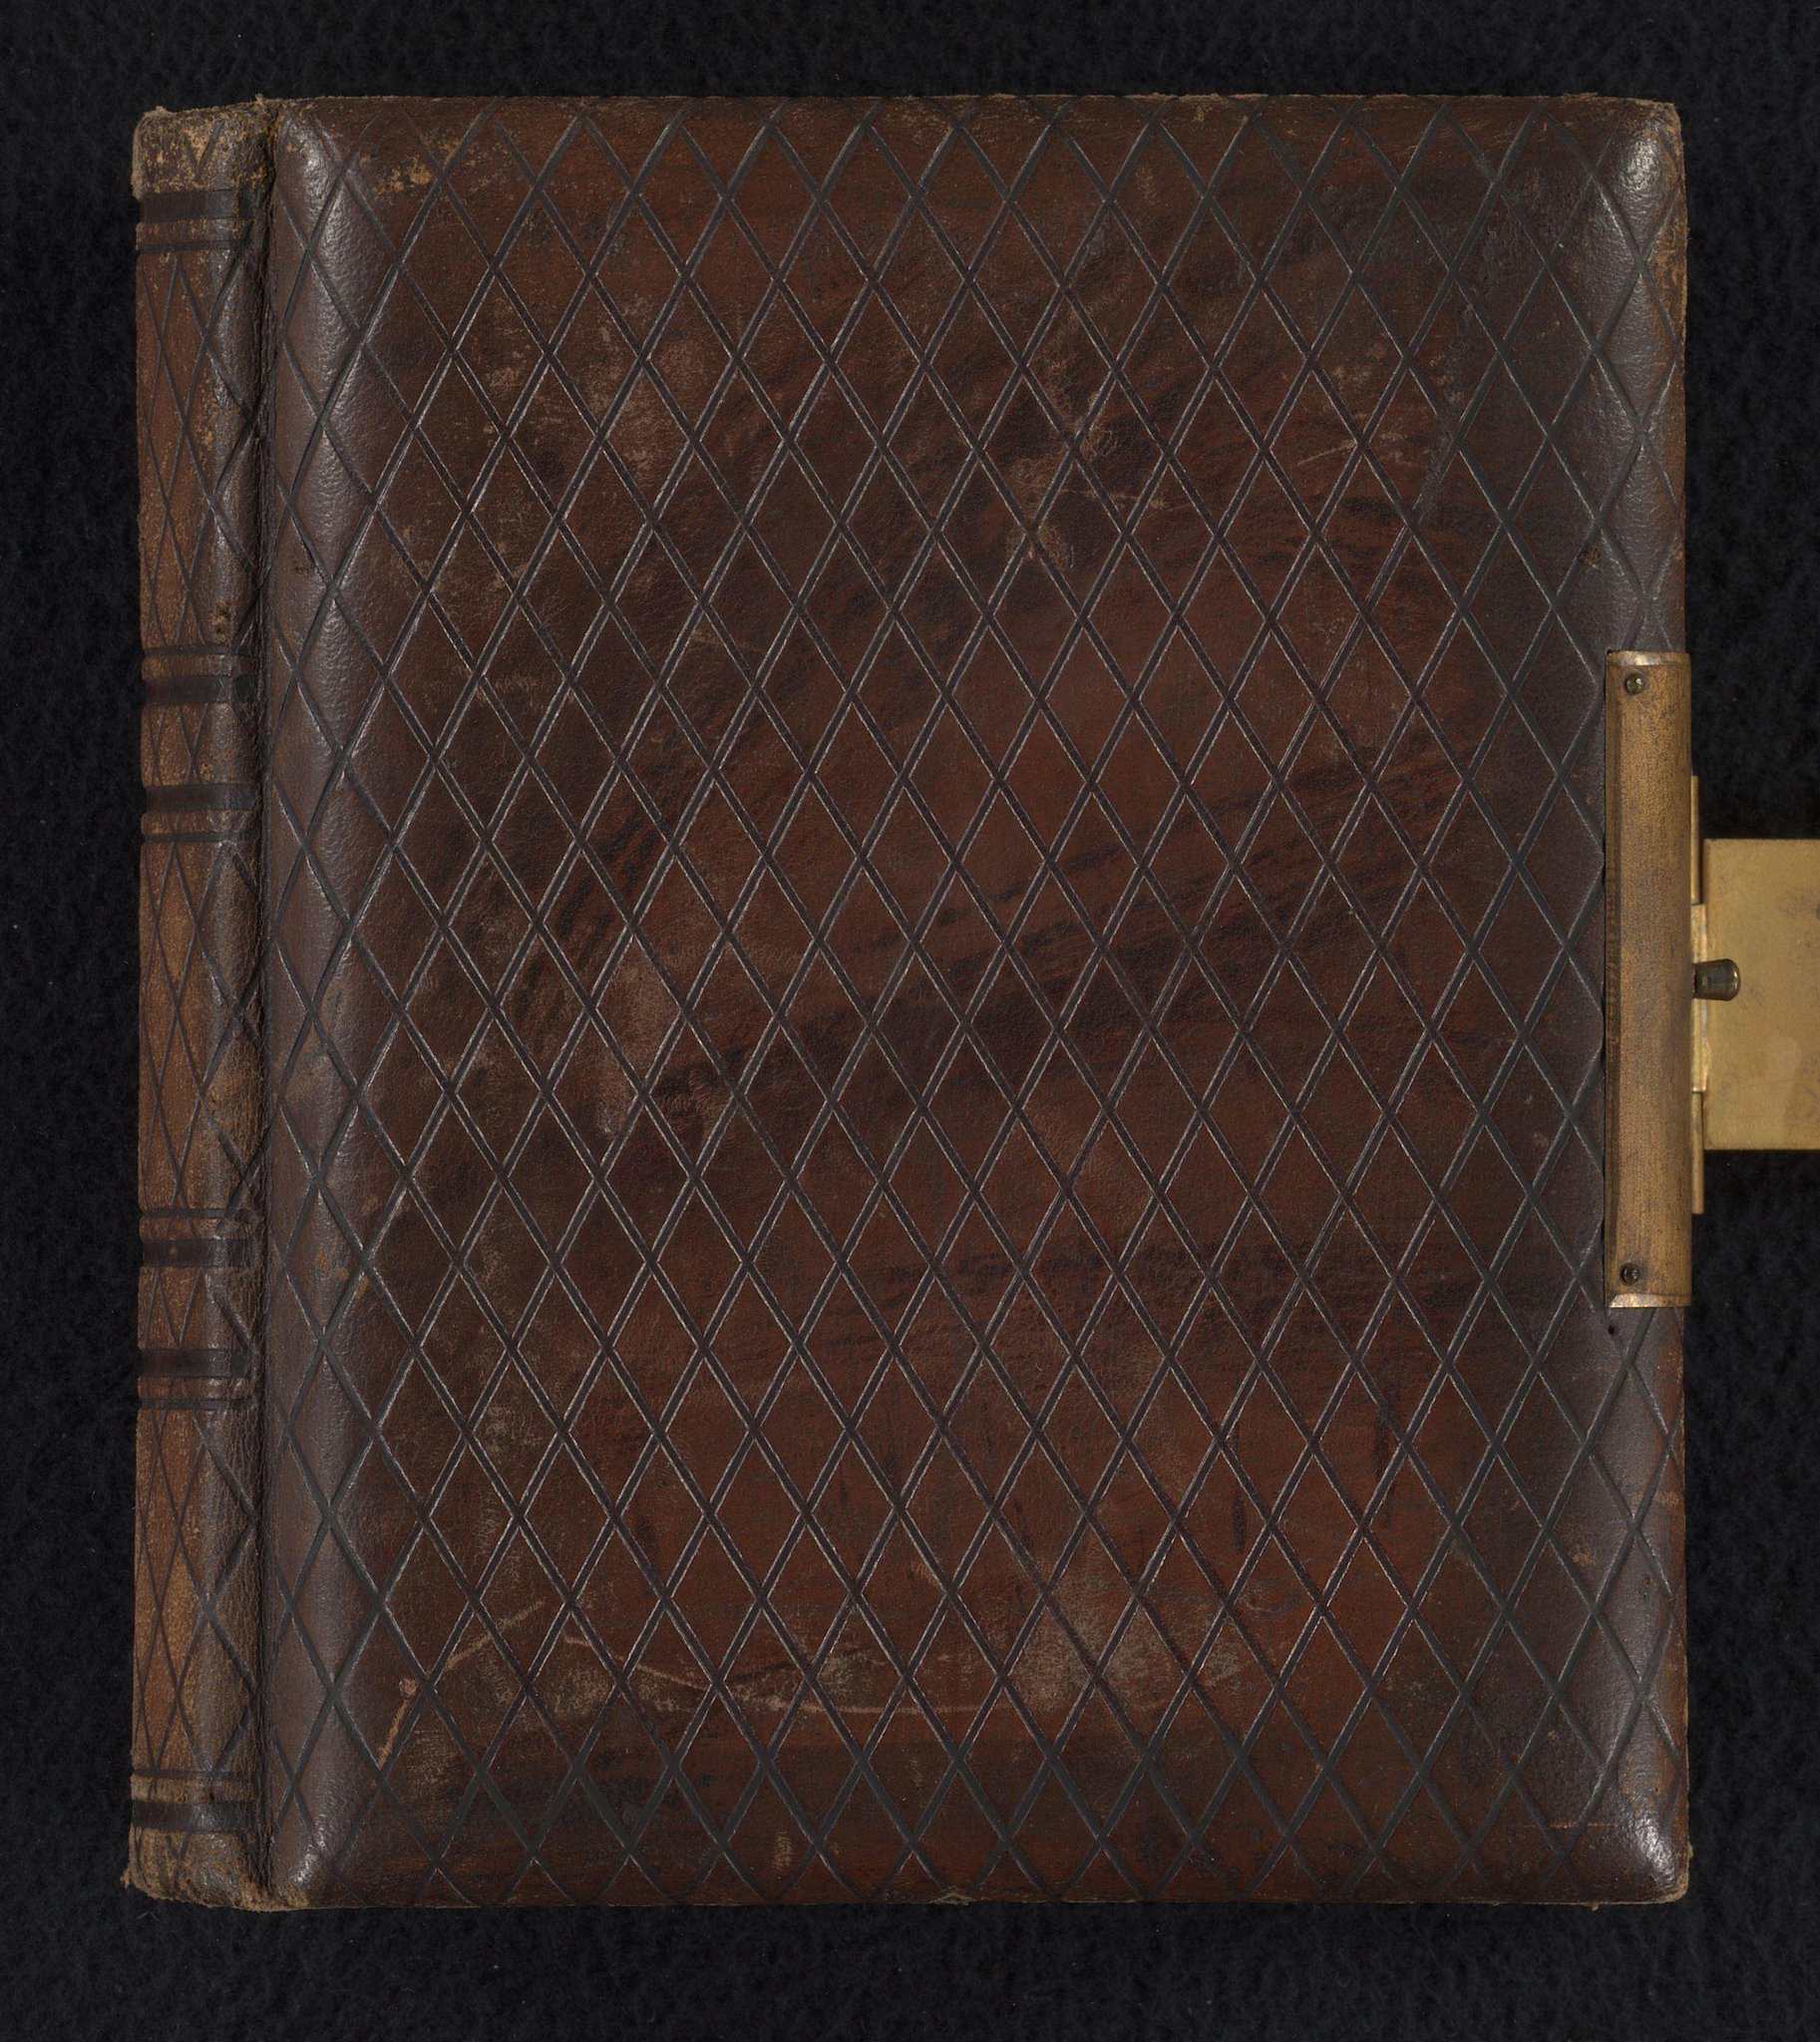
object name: slip in album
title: Fotoalbum (leeg)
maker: Anonymous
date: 1860-1900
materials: cardboard, leather, metal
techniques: color on snow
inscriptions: collector's mark: ‘Dienst Versprede Rijkskollekties/ (...)’